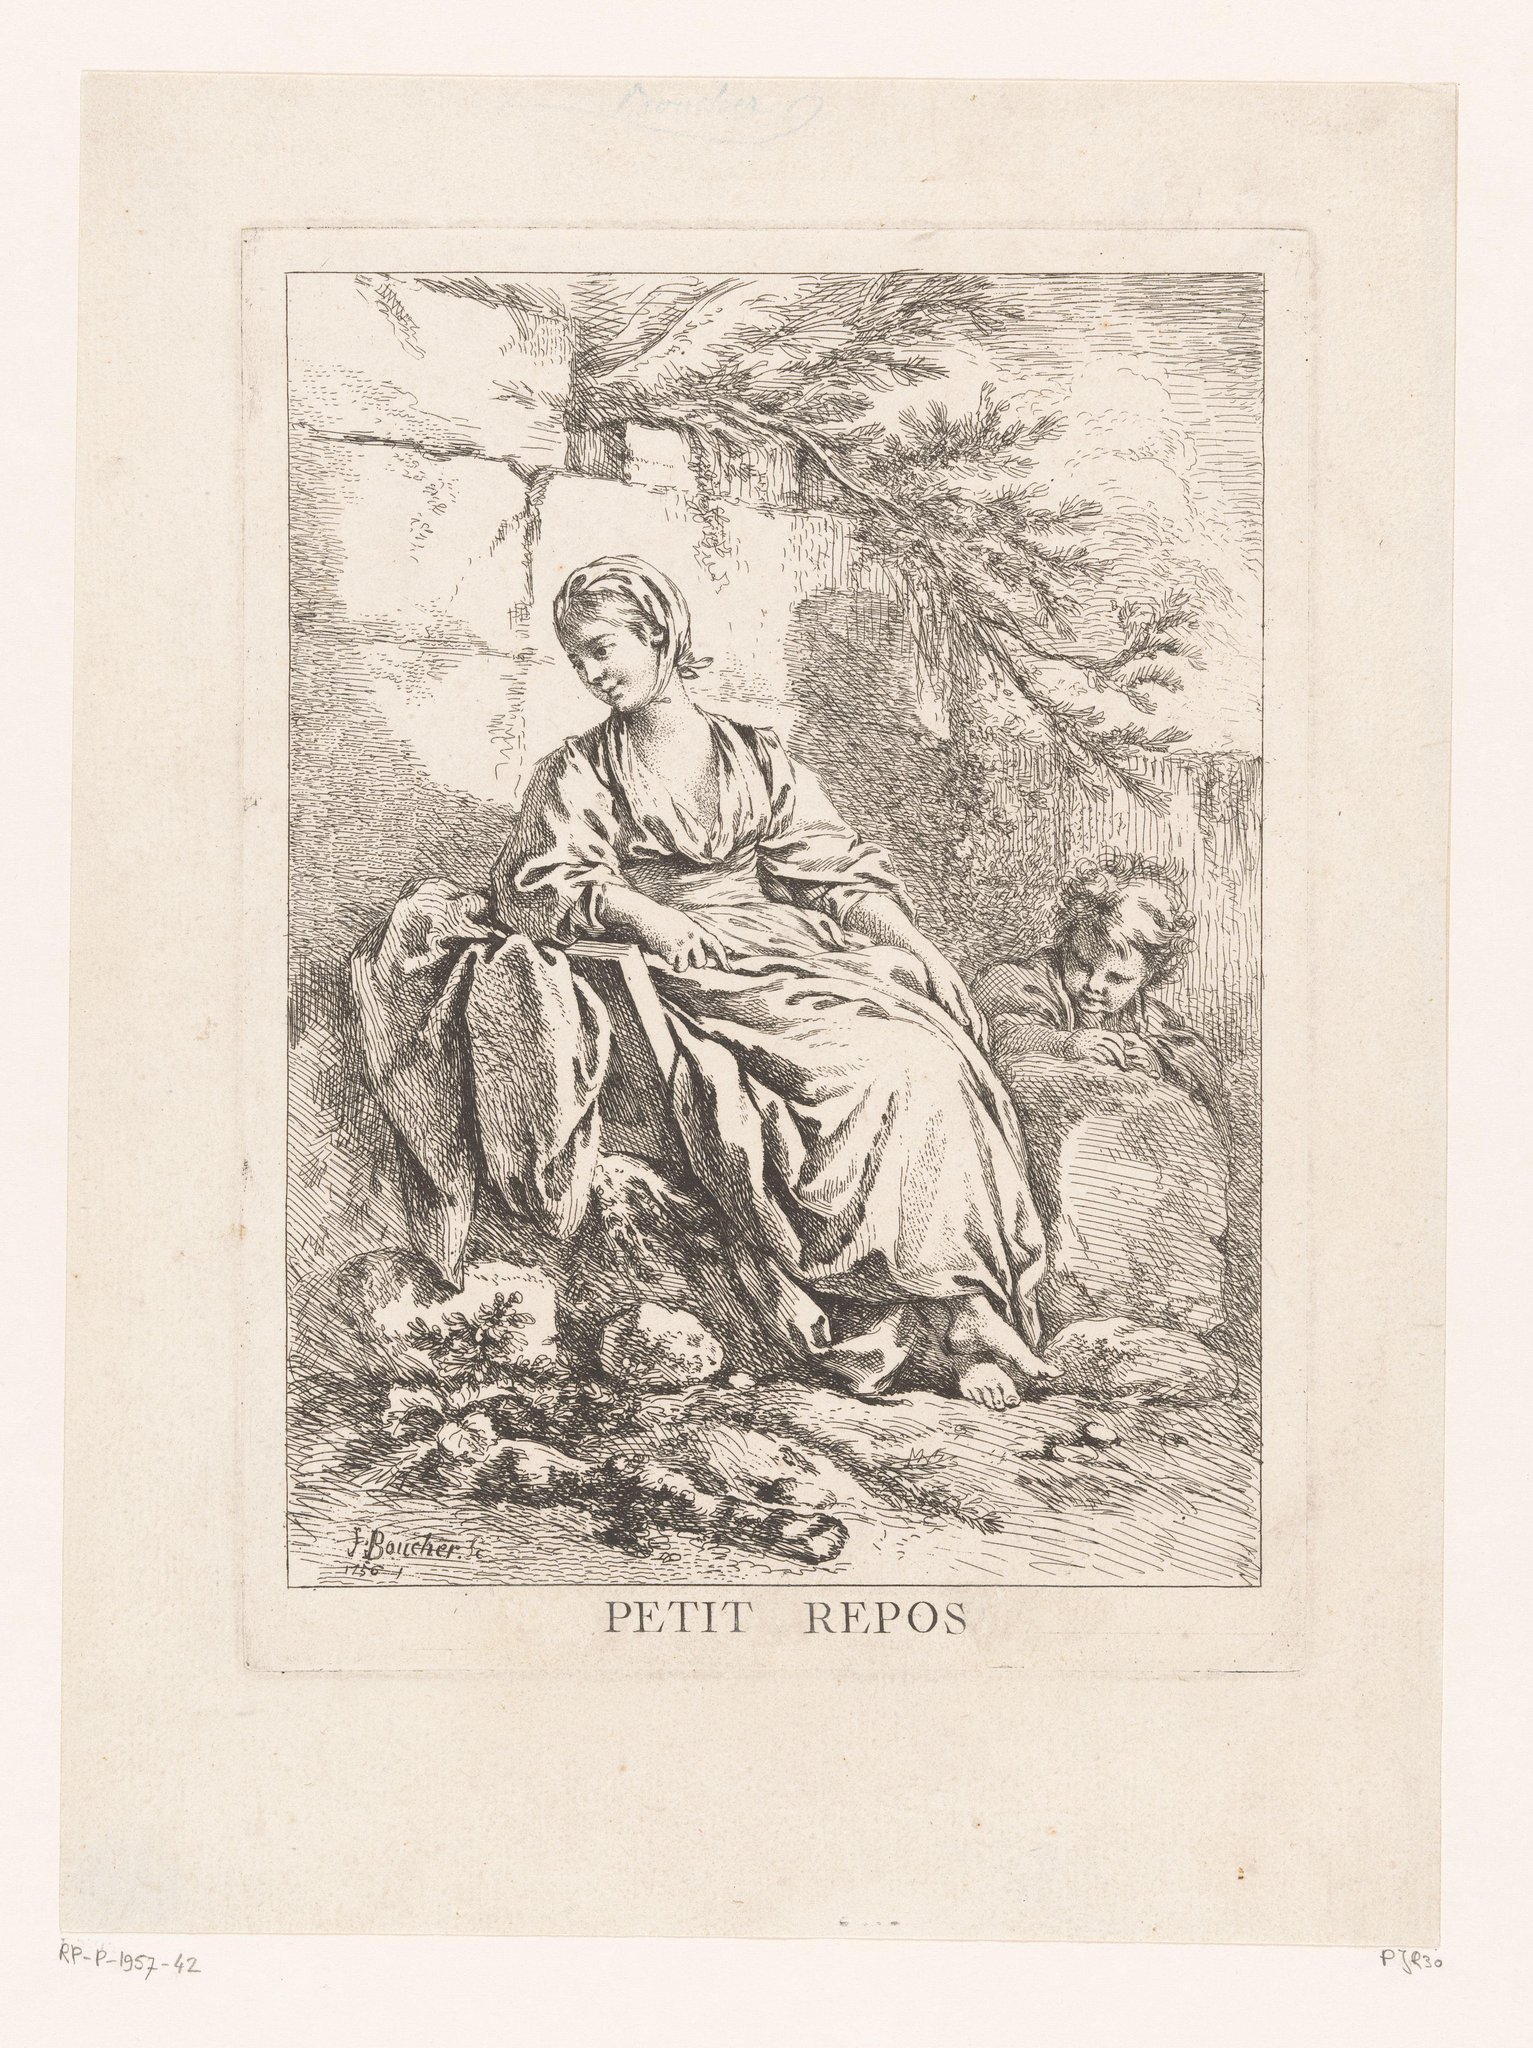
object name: print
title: Rustende jonge vrouw en kind bij een muur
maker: françois boucher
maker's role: draughtsman, print maker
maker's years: 1703-1770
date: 1756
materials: paper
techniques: etching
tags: mother and baby or young child, resting - bb - out of doors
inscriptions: collector's mark: Lugt 2228